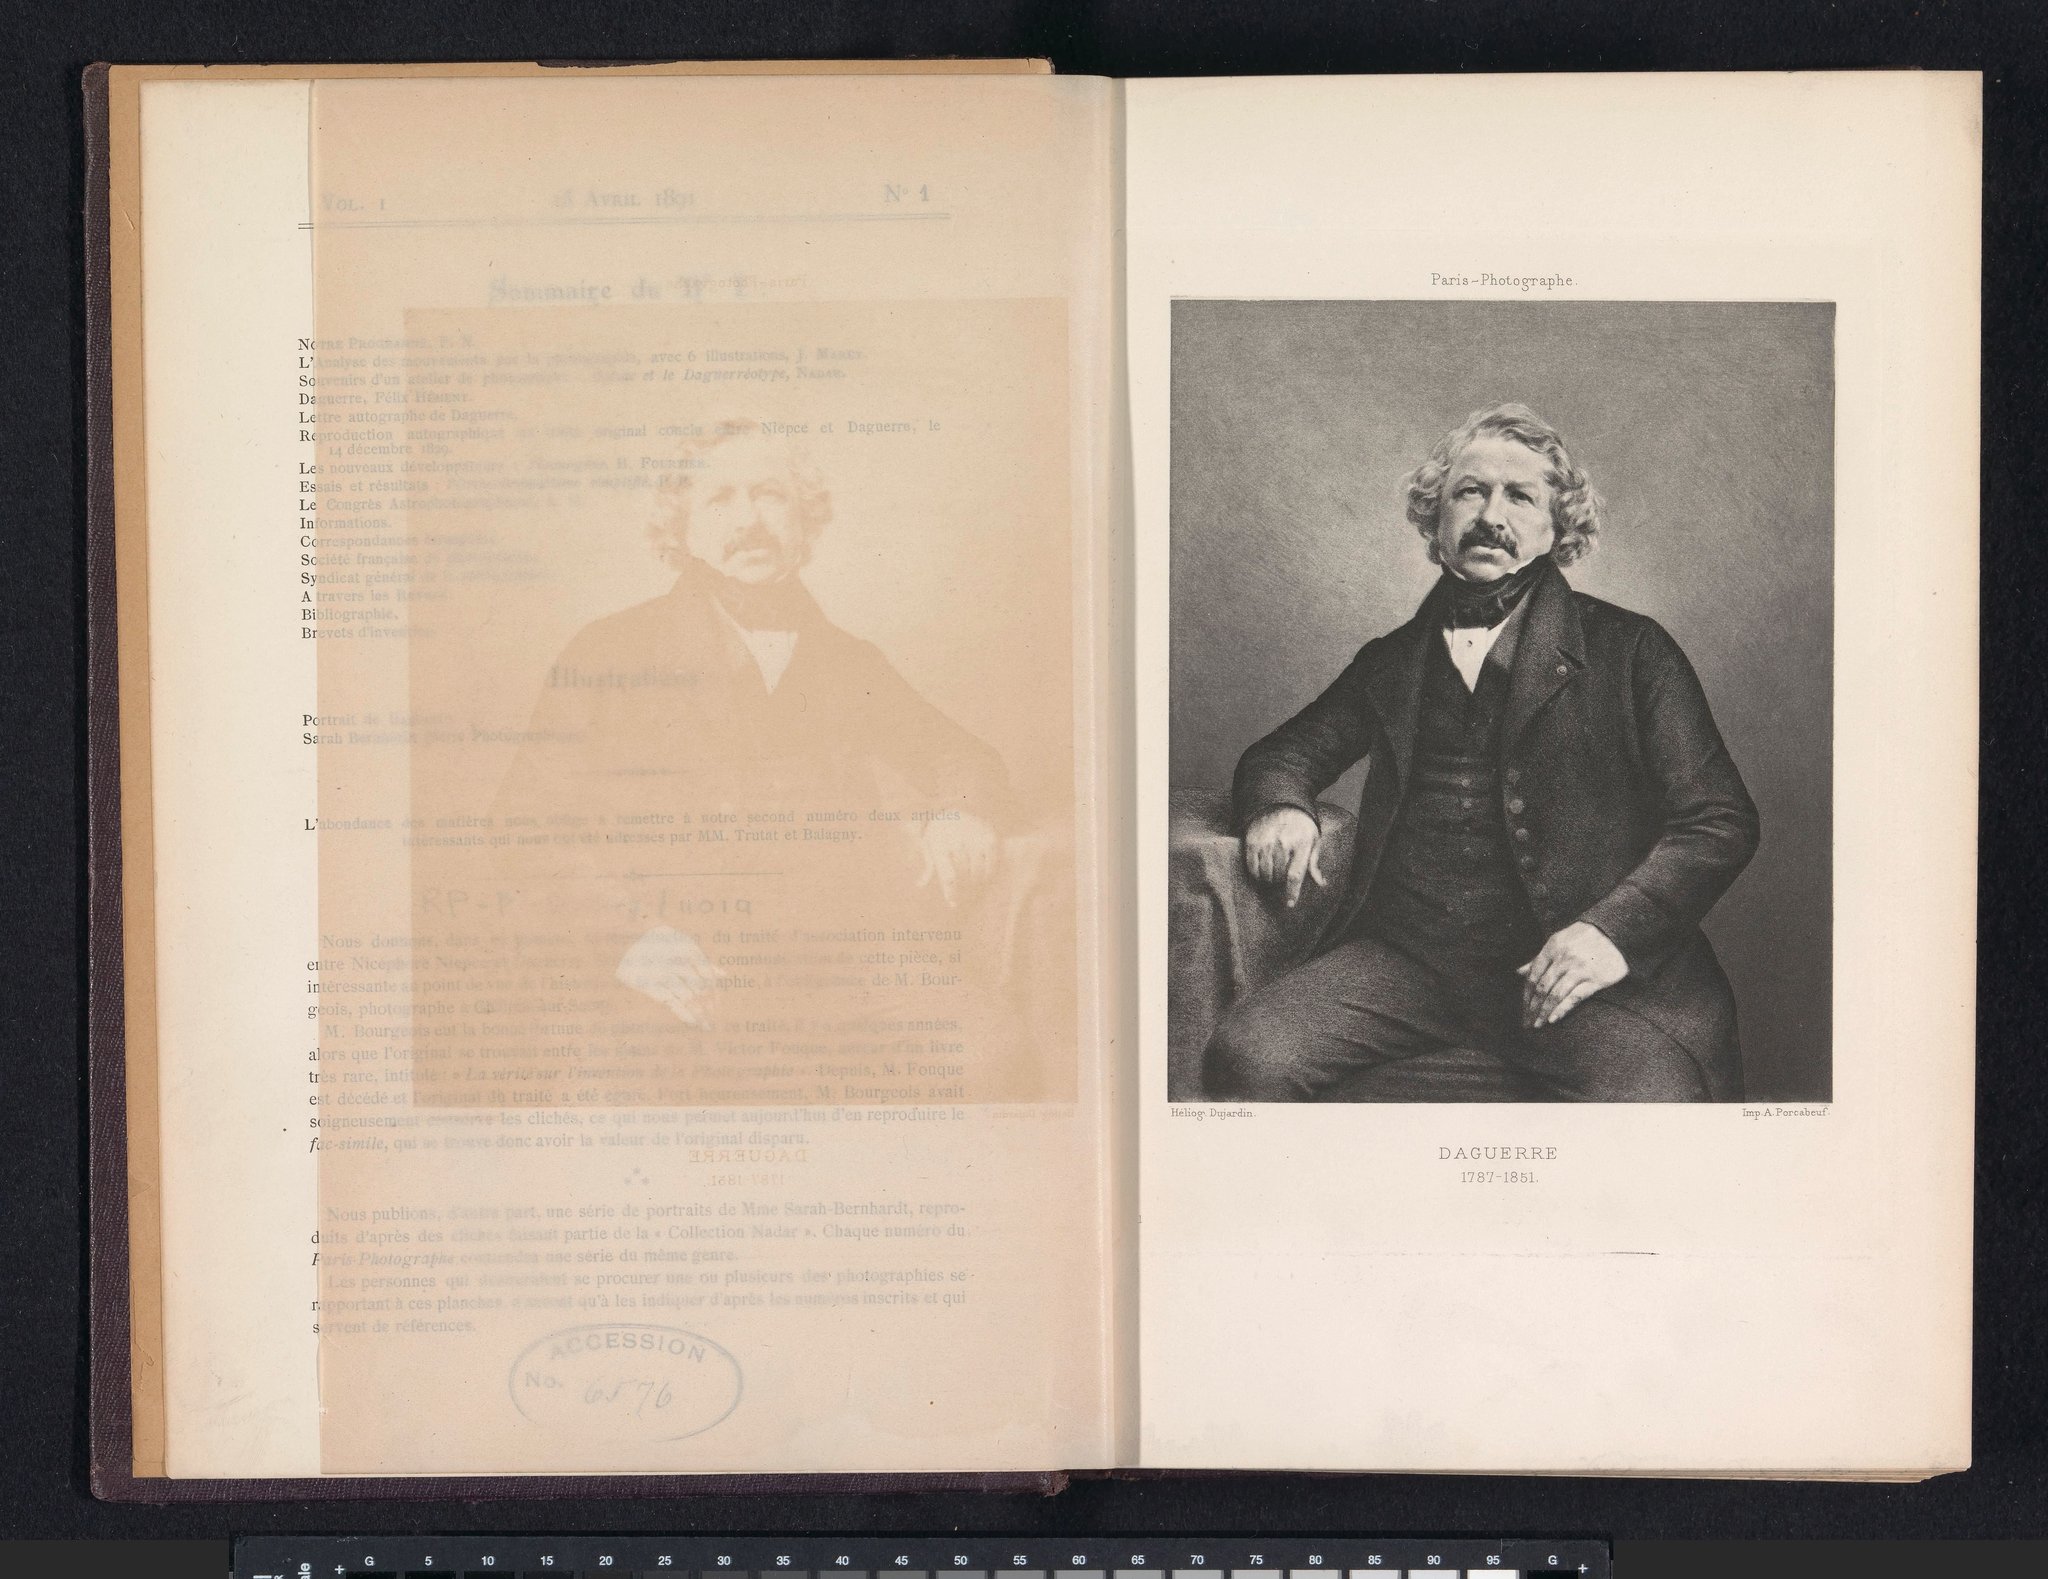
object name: reproduction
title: Daguerre 1787-1851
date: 1881-1891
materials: paper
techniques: photoaquatint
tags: louis jacques mandé daguerre, photographer in non-work situation